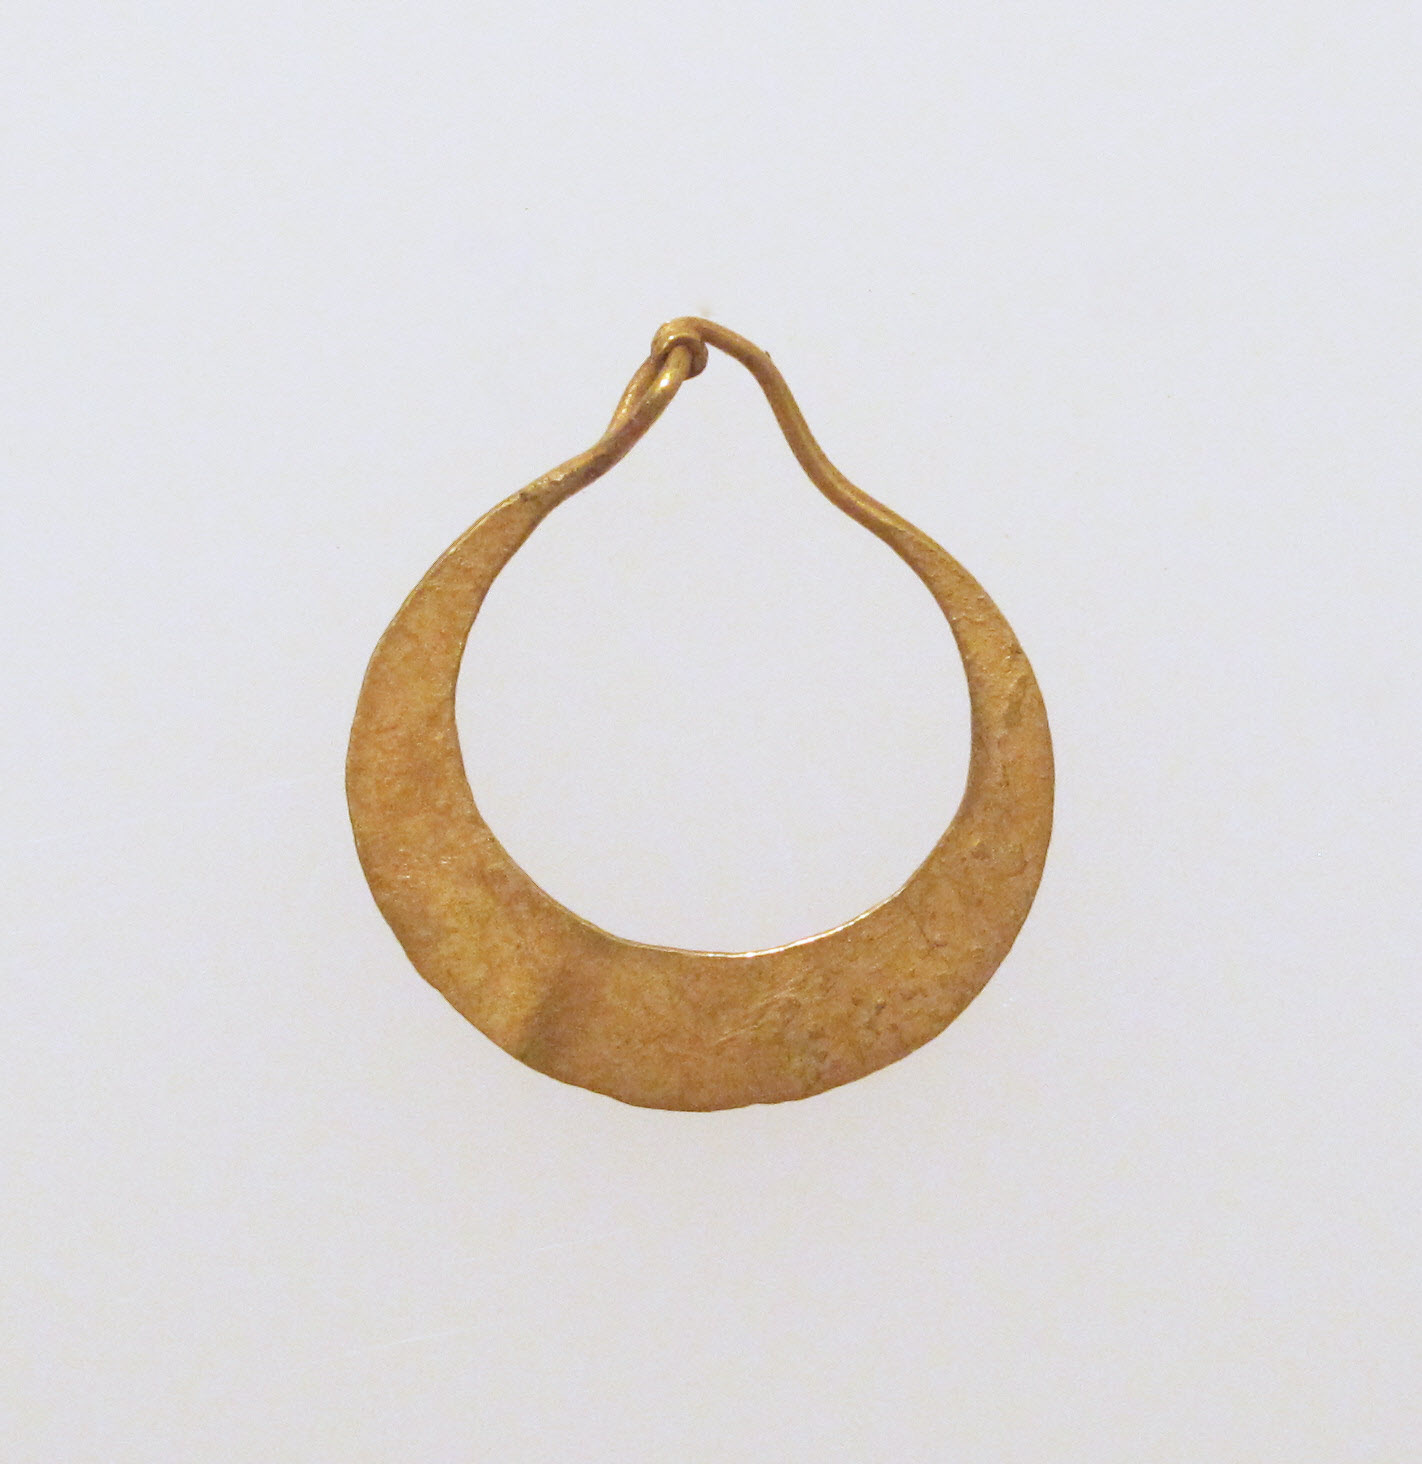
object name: earring, crescent shaped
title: Earring, crescent-shaped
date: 7000 BCE-330 CE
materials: gold